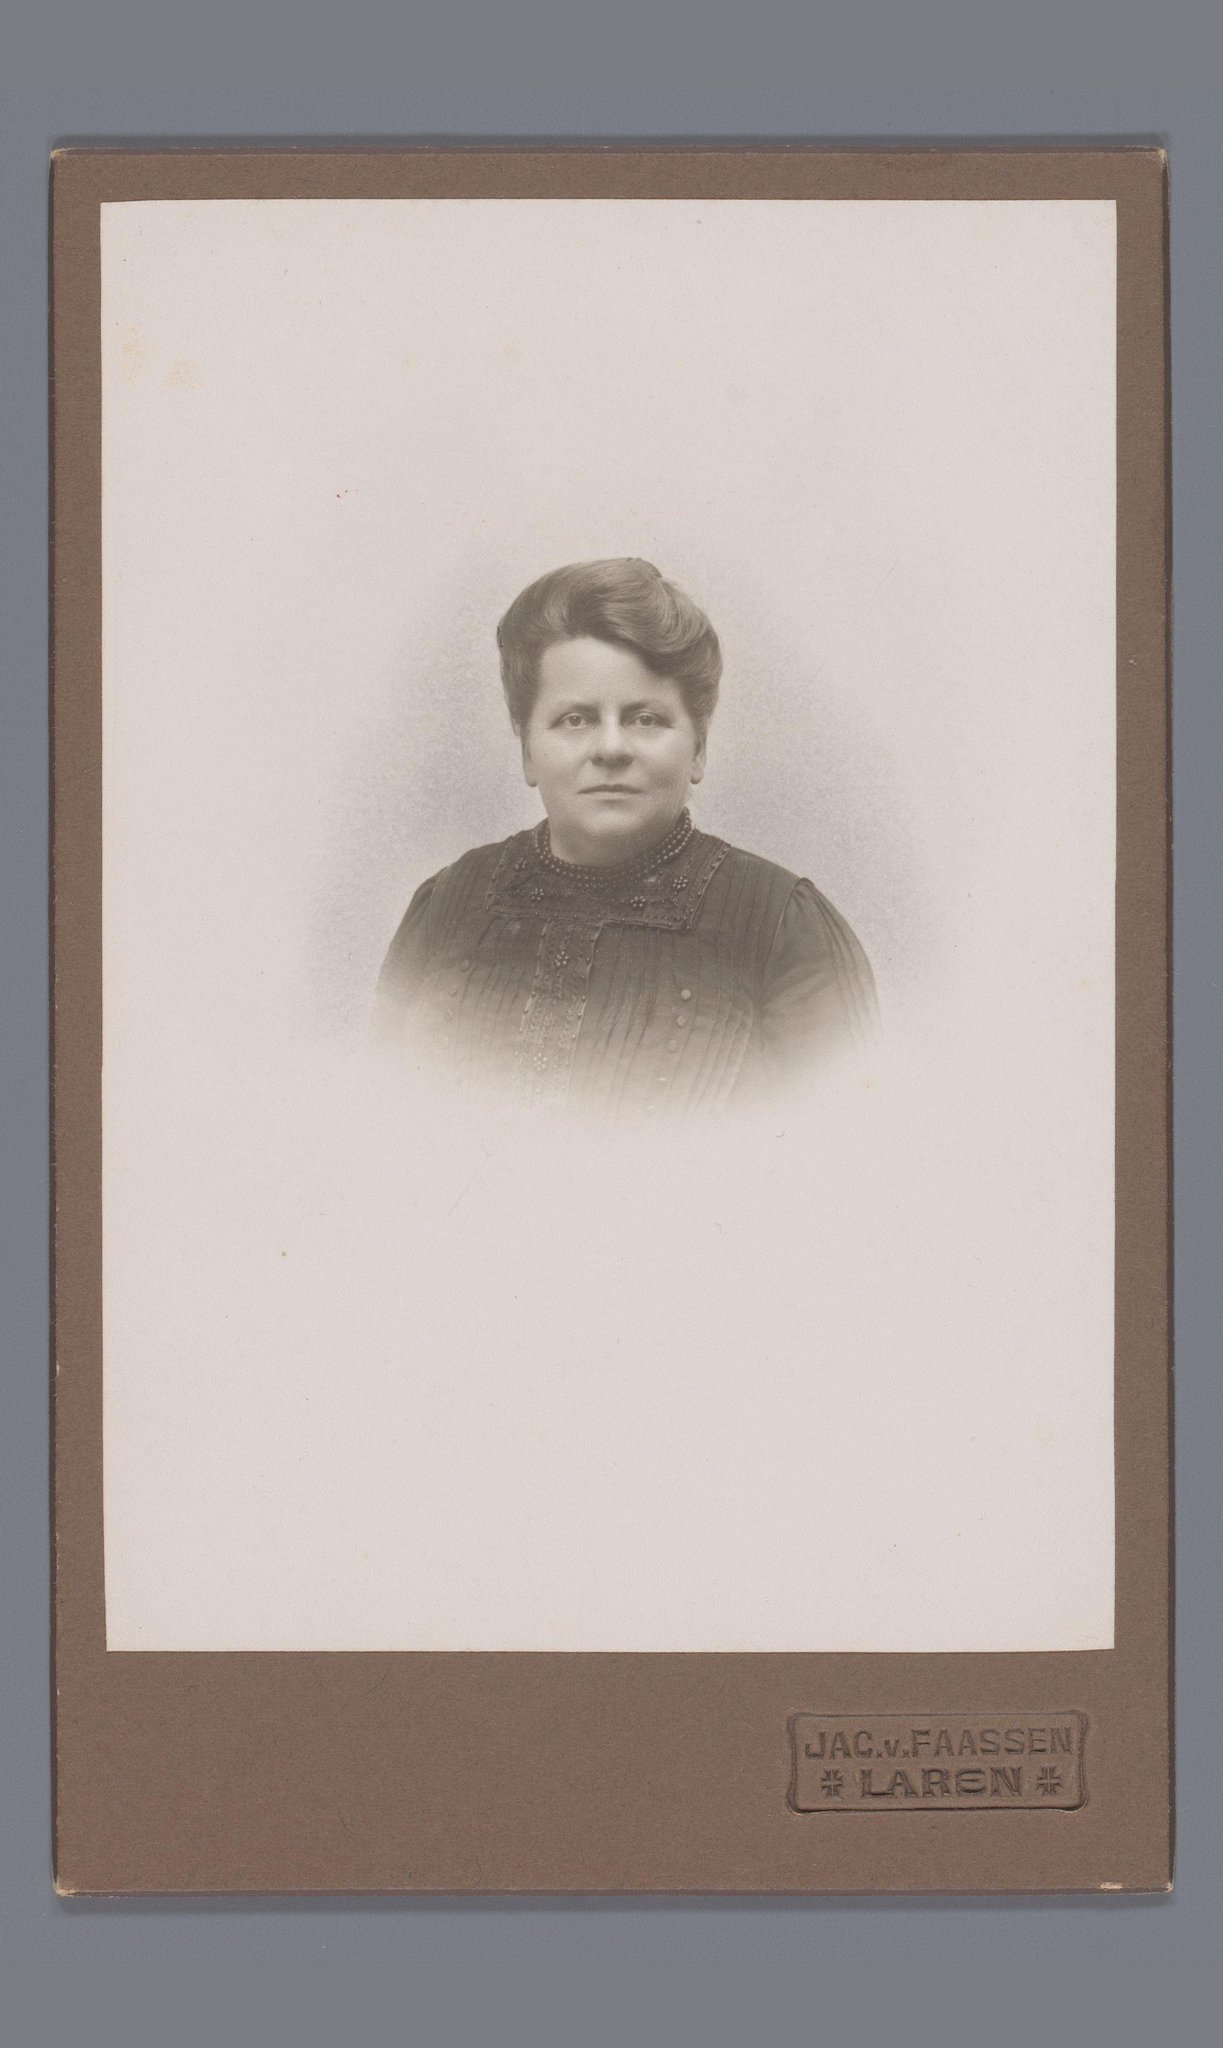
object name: cabinet photograph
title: Portret van Christina Maria Lucie Langhout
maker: jac. van faassen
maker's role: fotograaf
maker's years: 1876-1943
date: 1907-1922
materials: cardboard, photographic support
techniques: gelatin silver print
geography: laren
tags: historical persons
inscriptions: annotation: ‘Lucie Treus Langhout-Temmink’